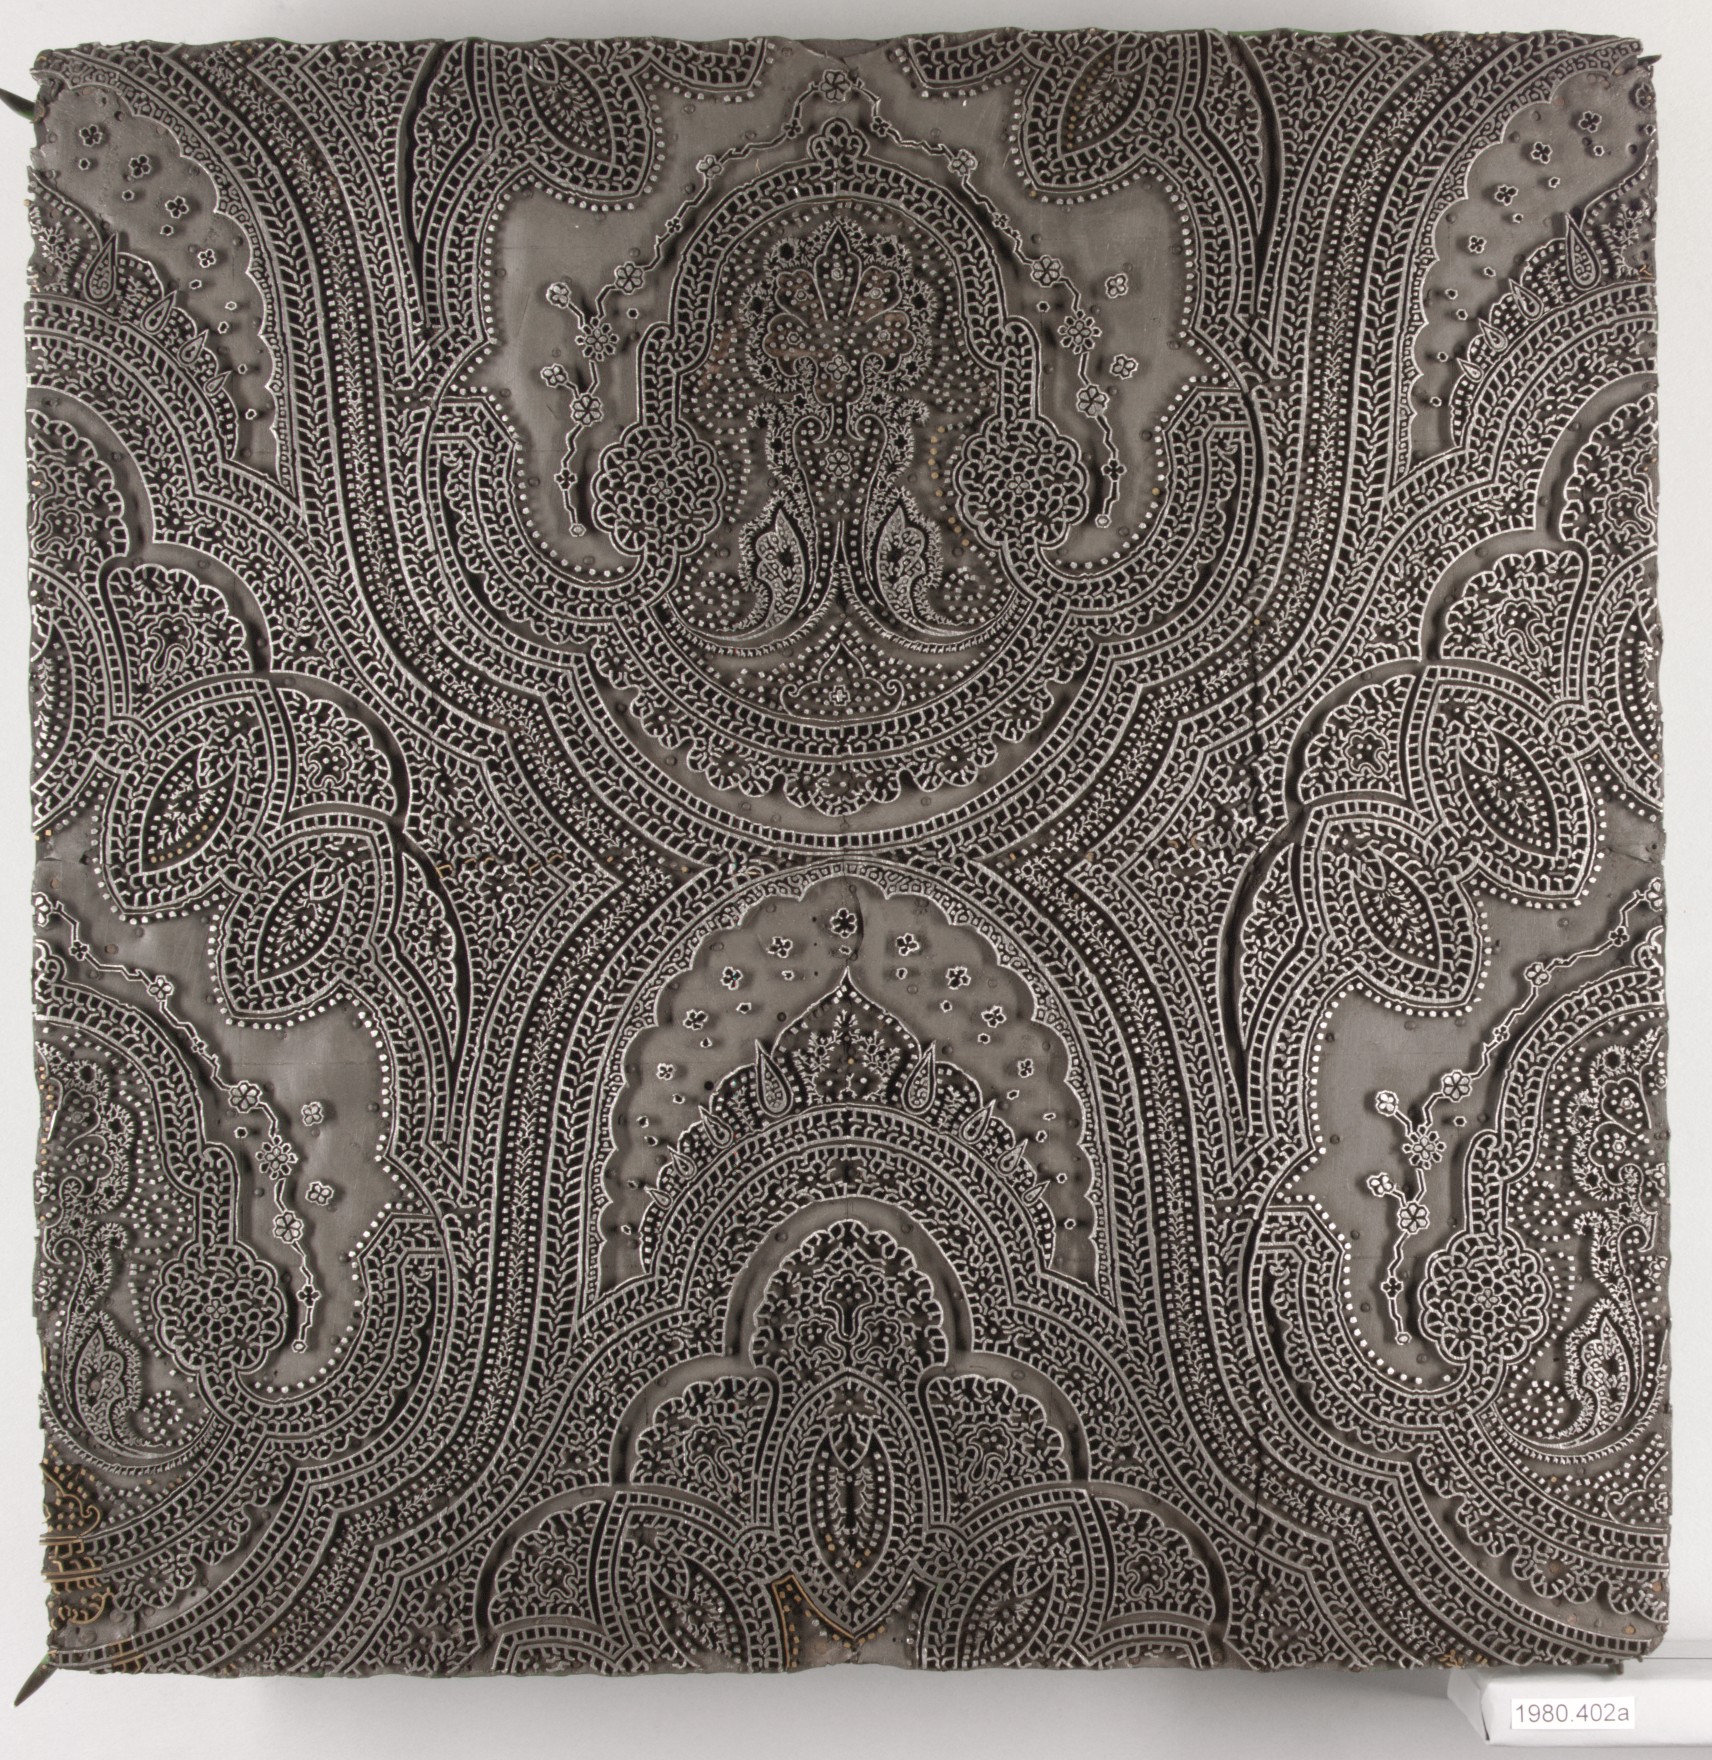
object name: woodblock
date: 1801-1900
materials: metal, wood